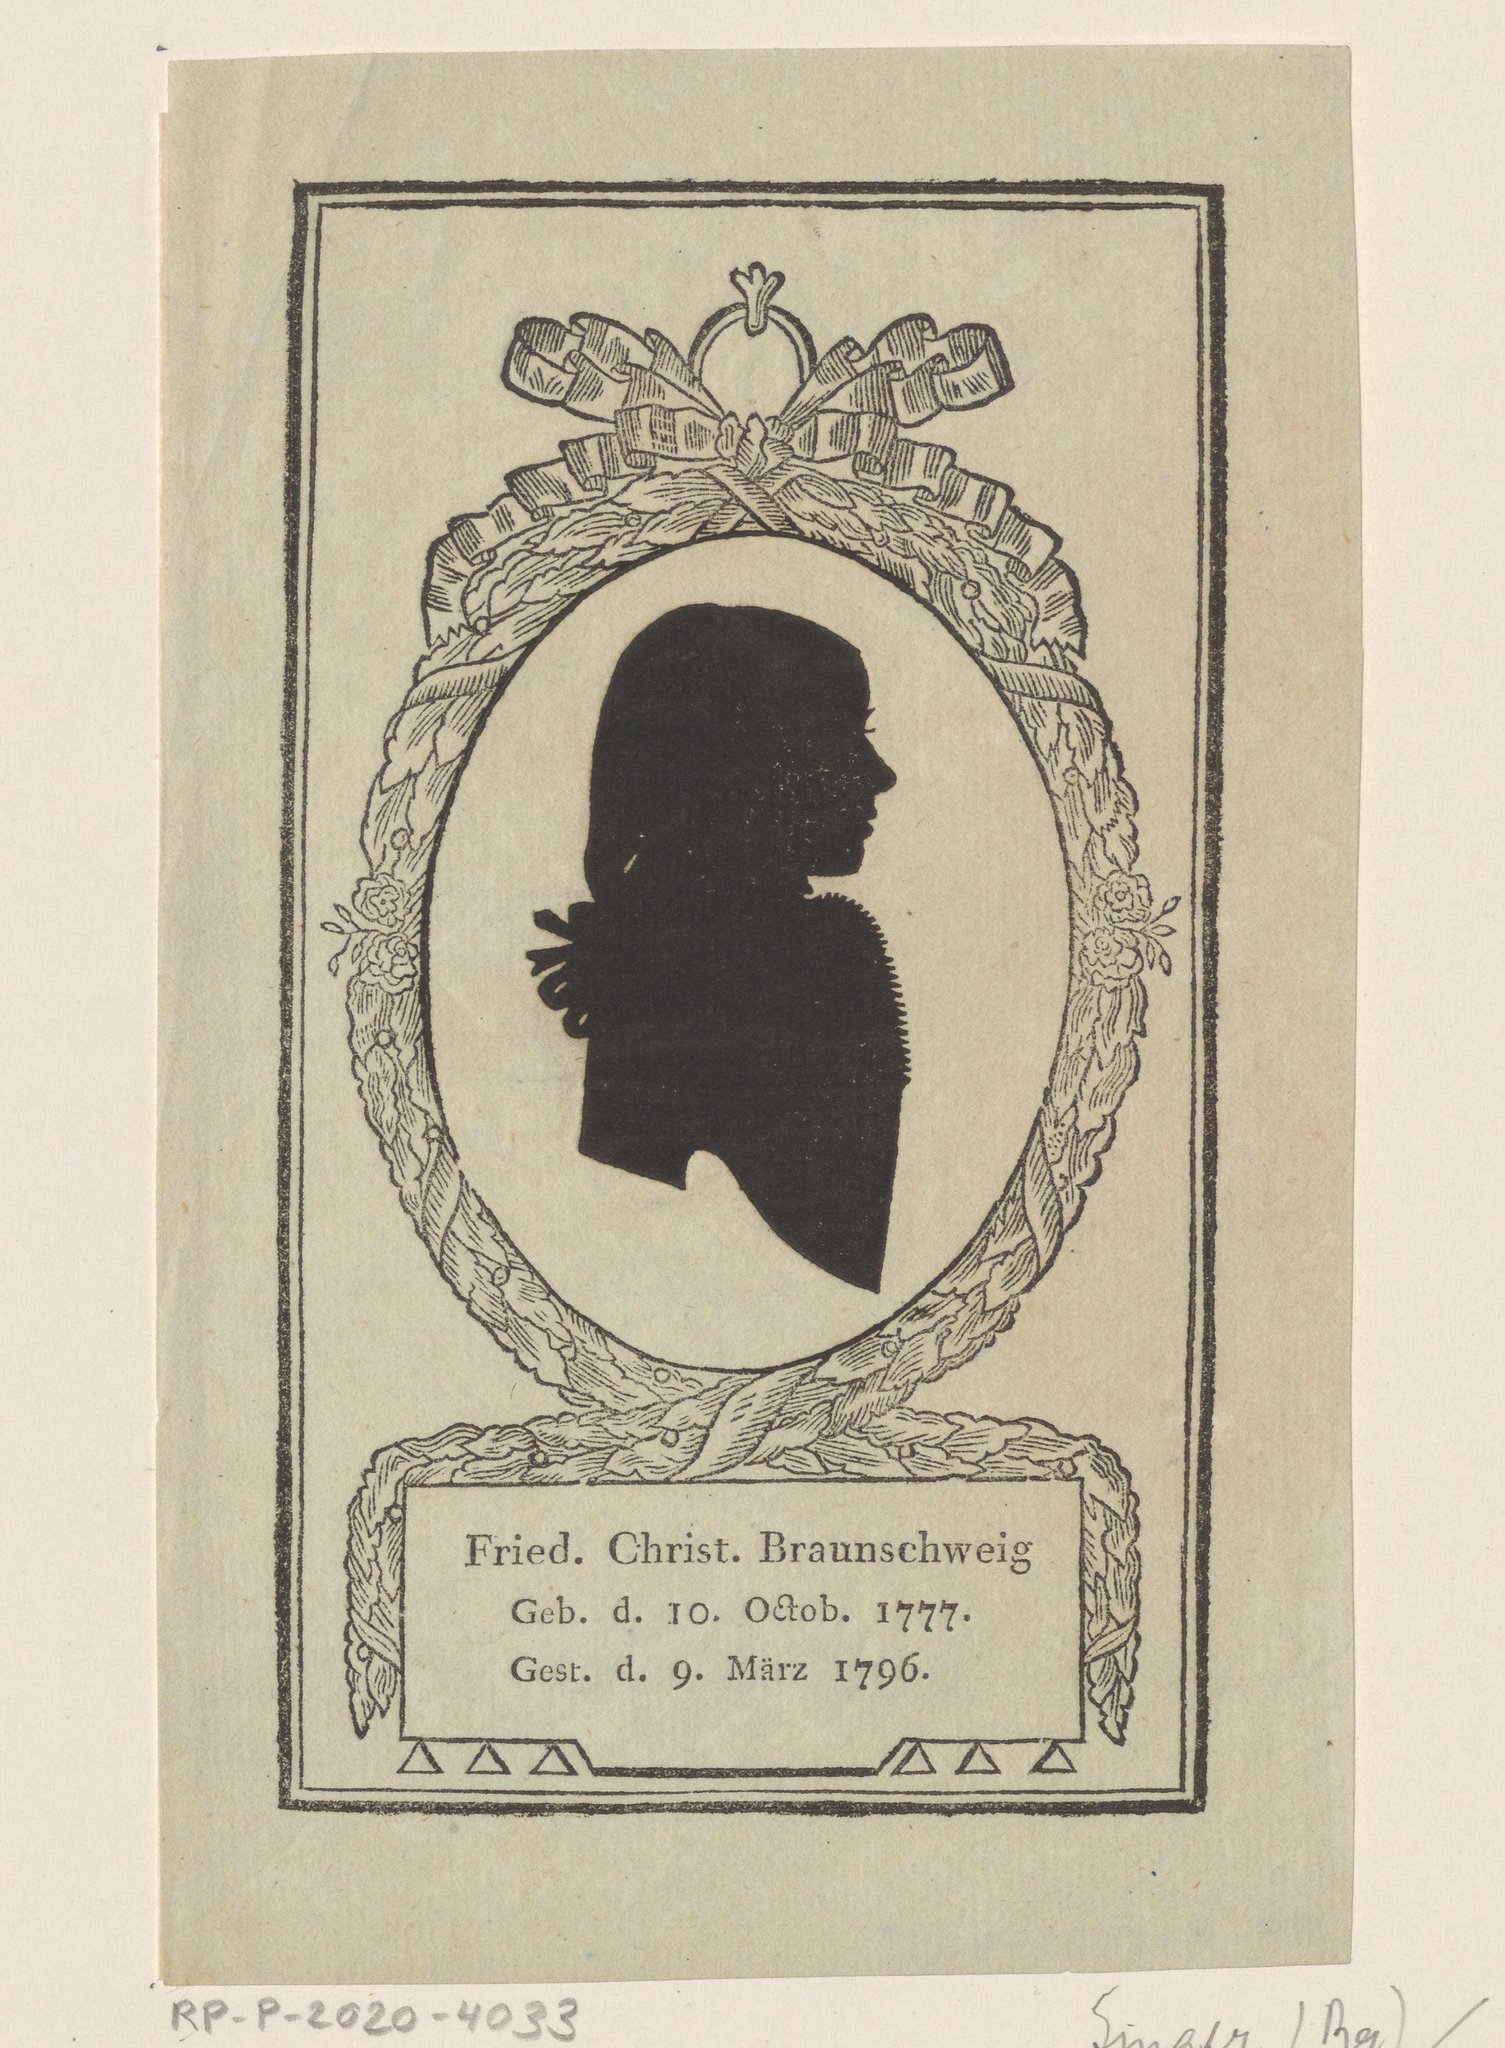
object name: print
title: Silhouetportret van Fried. Christ. Braunschweig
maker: Anonymous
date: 1796-1798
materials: paper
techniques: letterpress printing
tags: historical persons